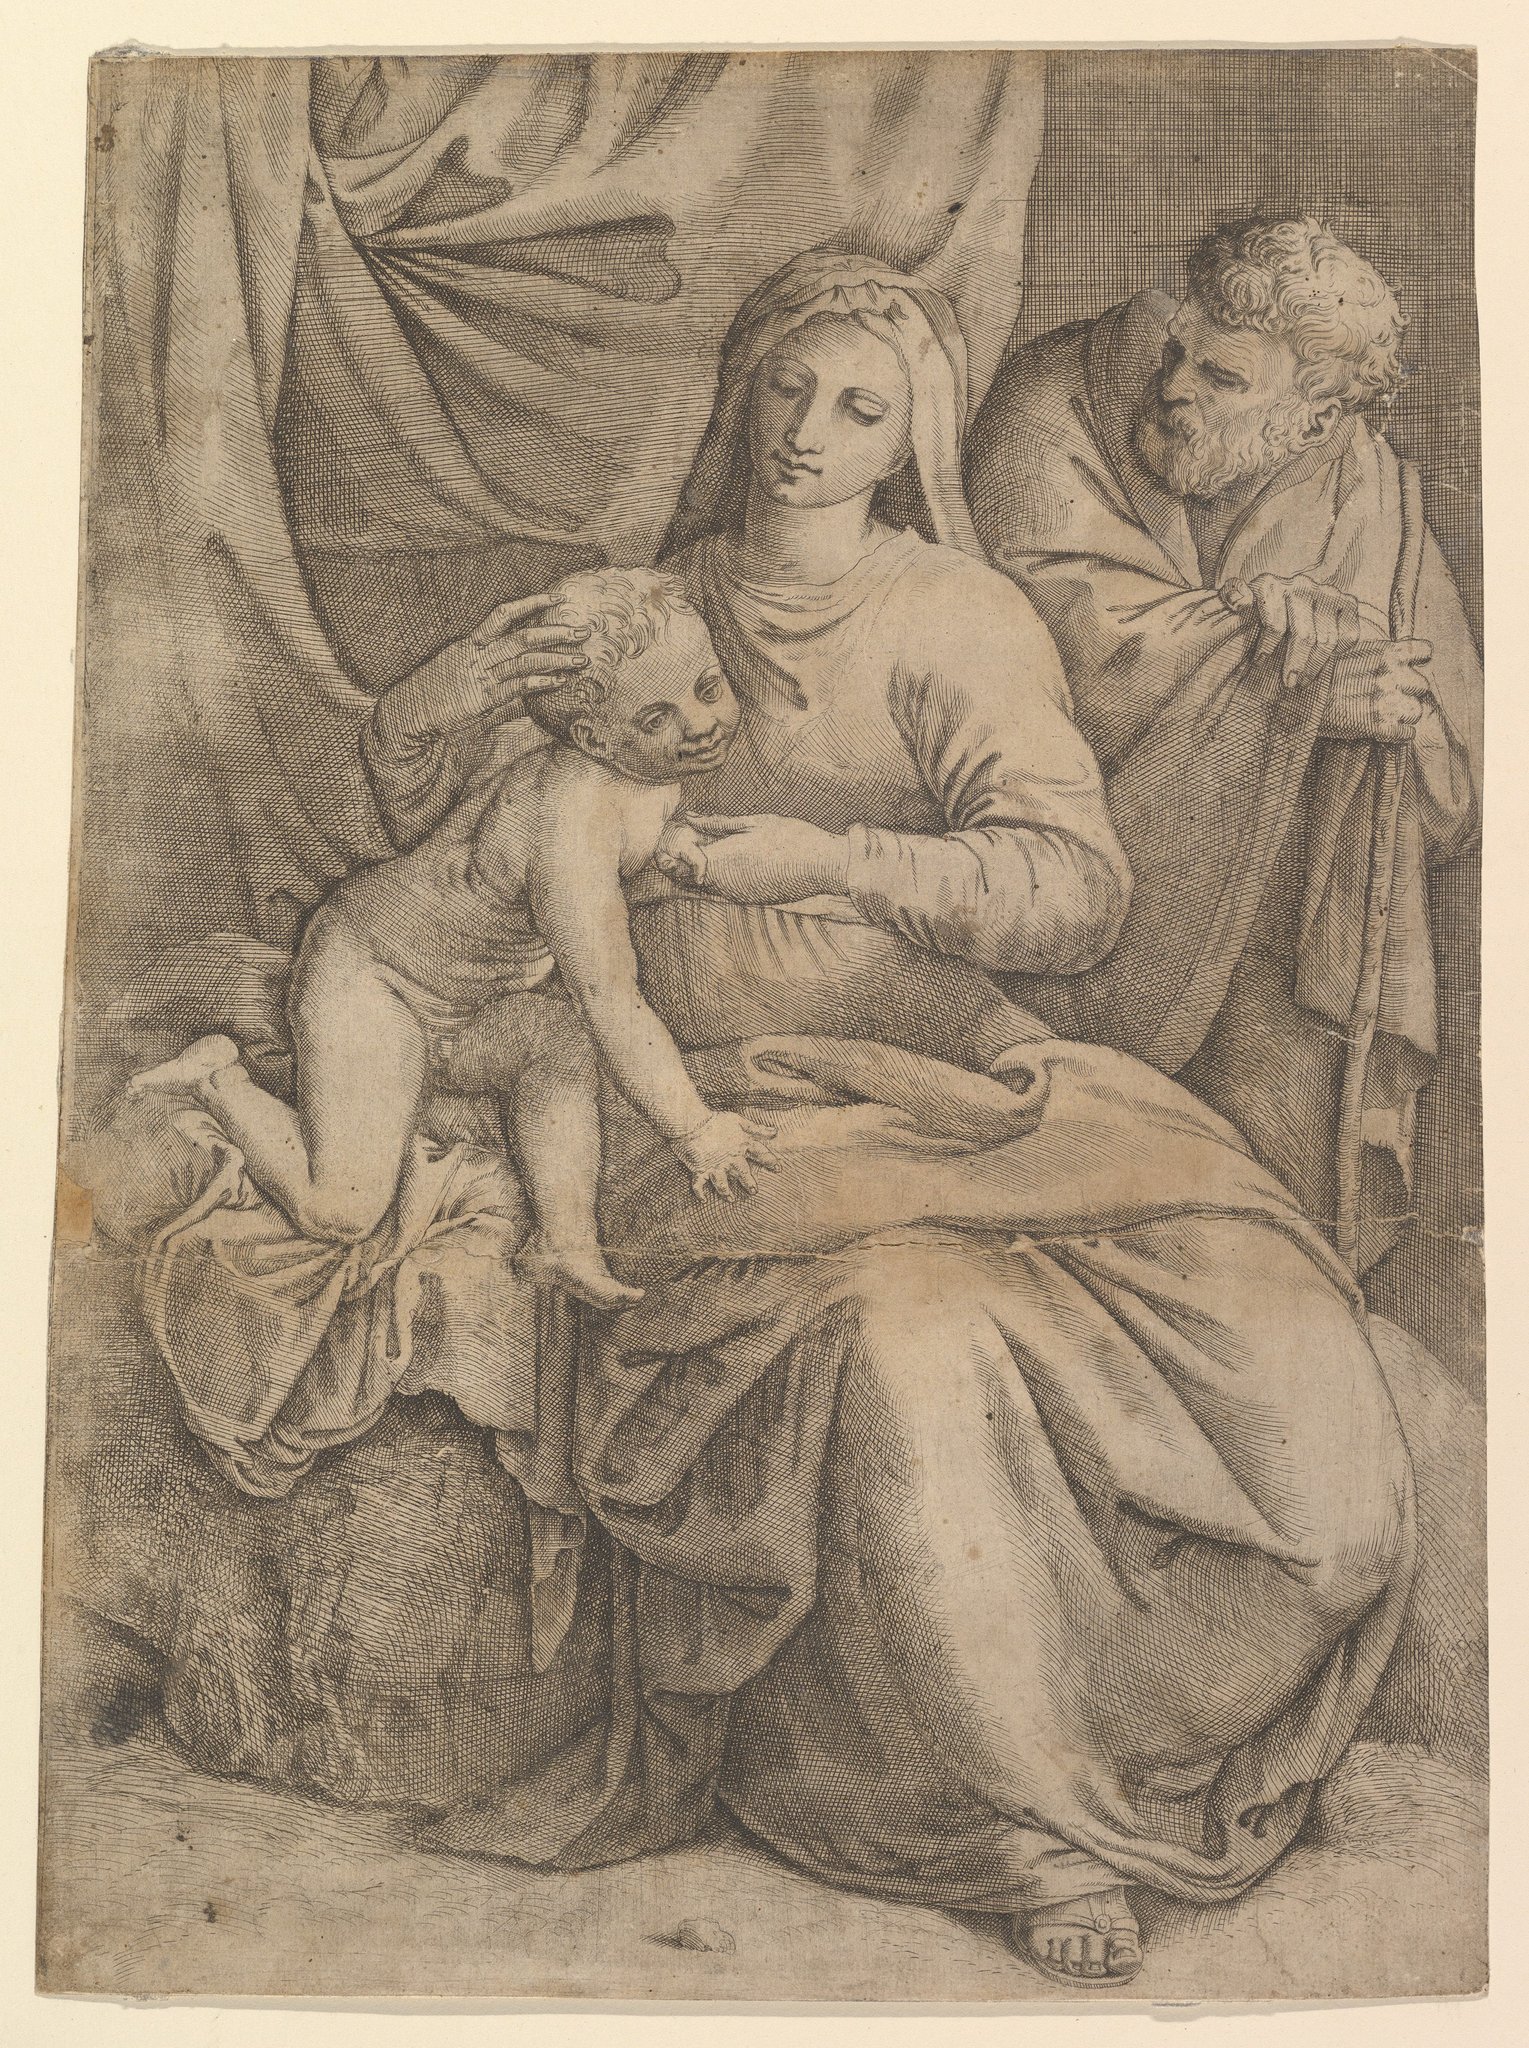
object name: print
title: The Holy Family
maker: battista franco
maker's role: artist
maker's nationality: italian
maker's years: 1510-1561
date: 1510-1561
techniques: engraving, etching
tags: christ,holy family,saint joseph,virgin mary